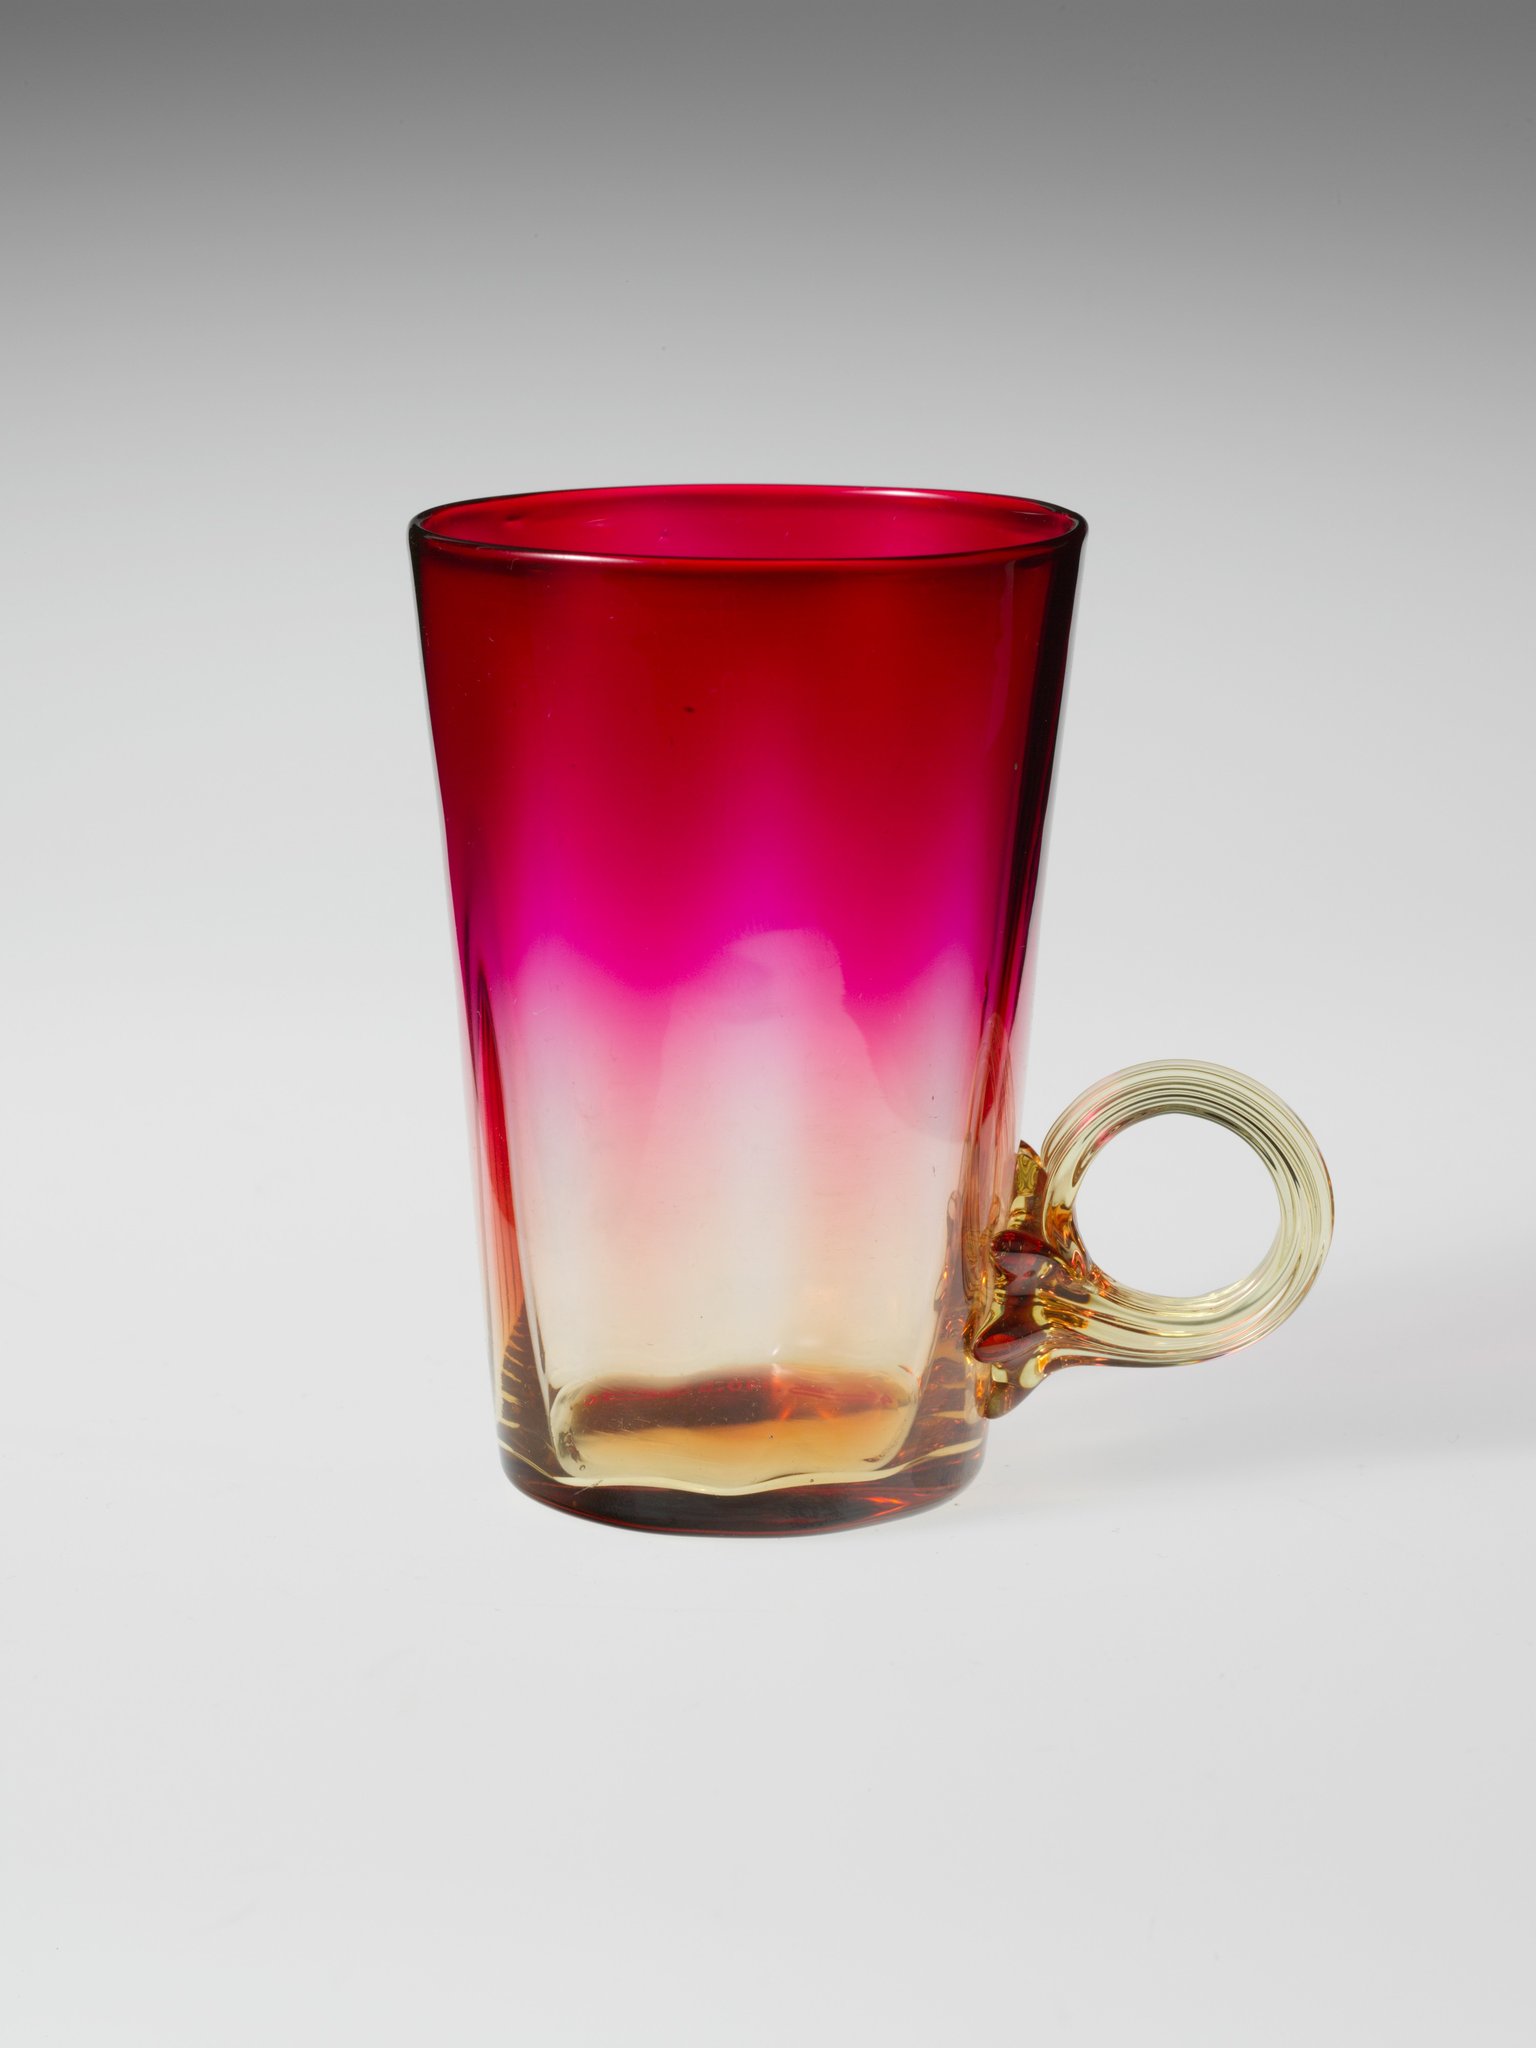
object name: punch glass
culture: american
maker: new england glass company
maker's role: maker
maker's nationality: american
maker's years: 1818-1888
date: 1883-1888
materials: glass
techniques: glassblowing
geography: united states